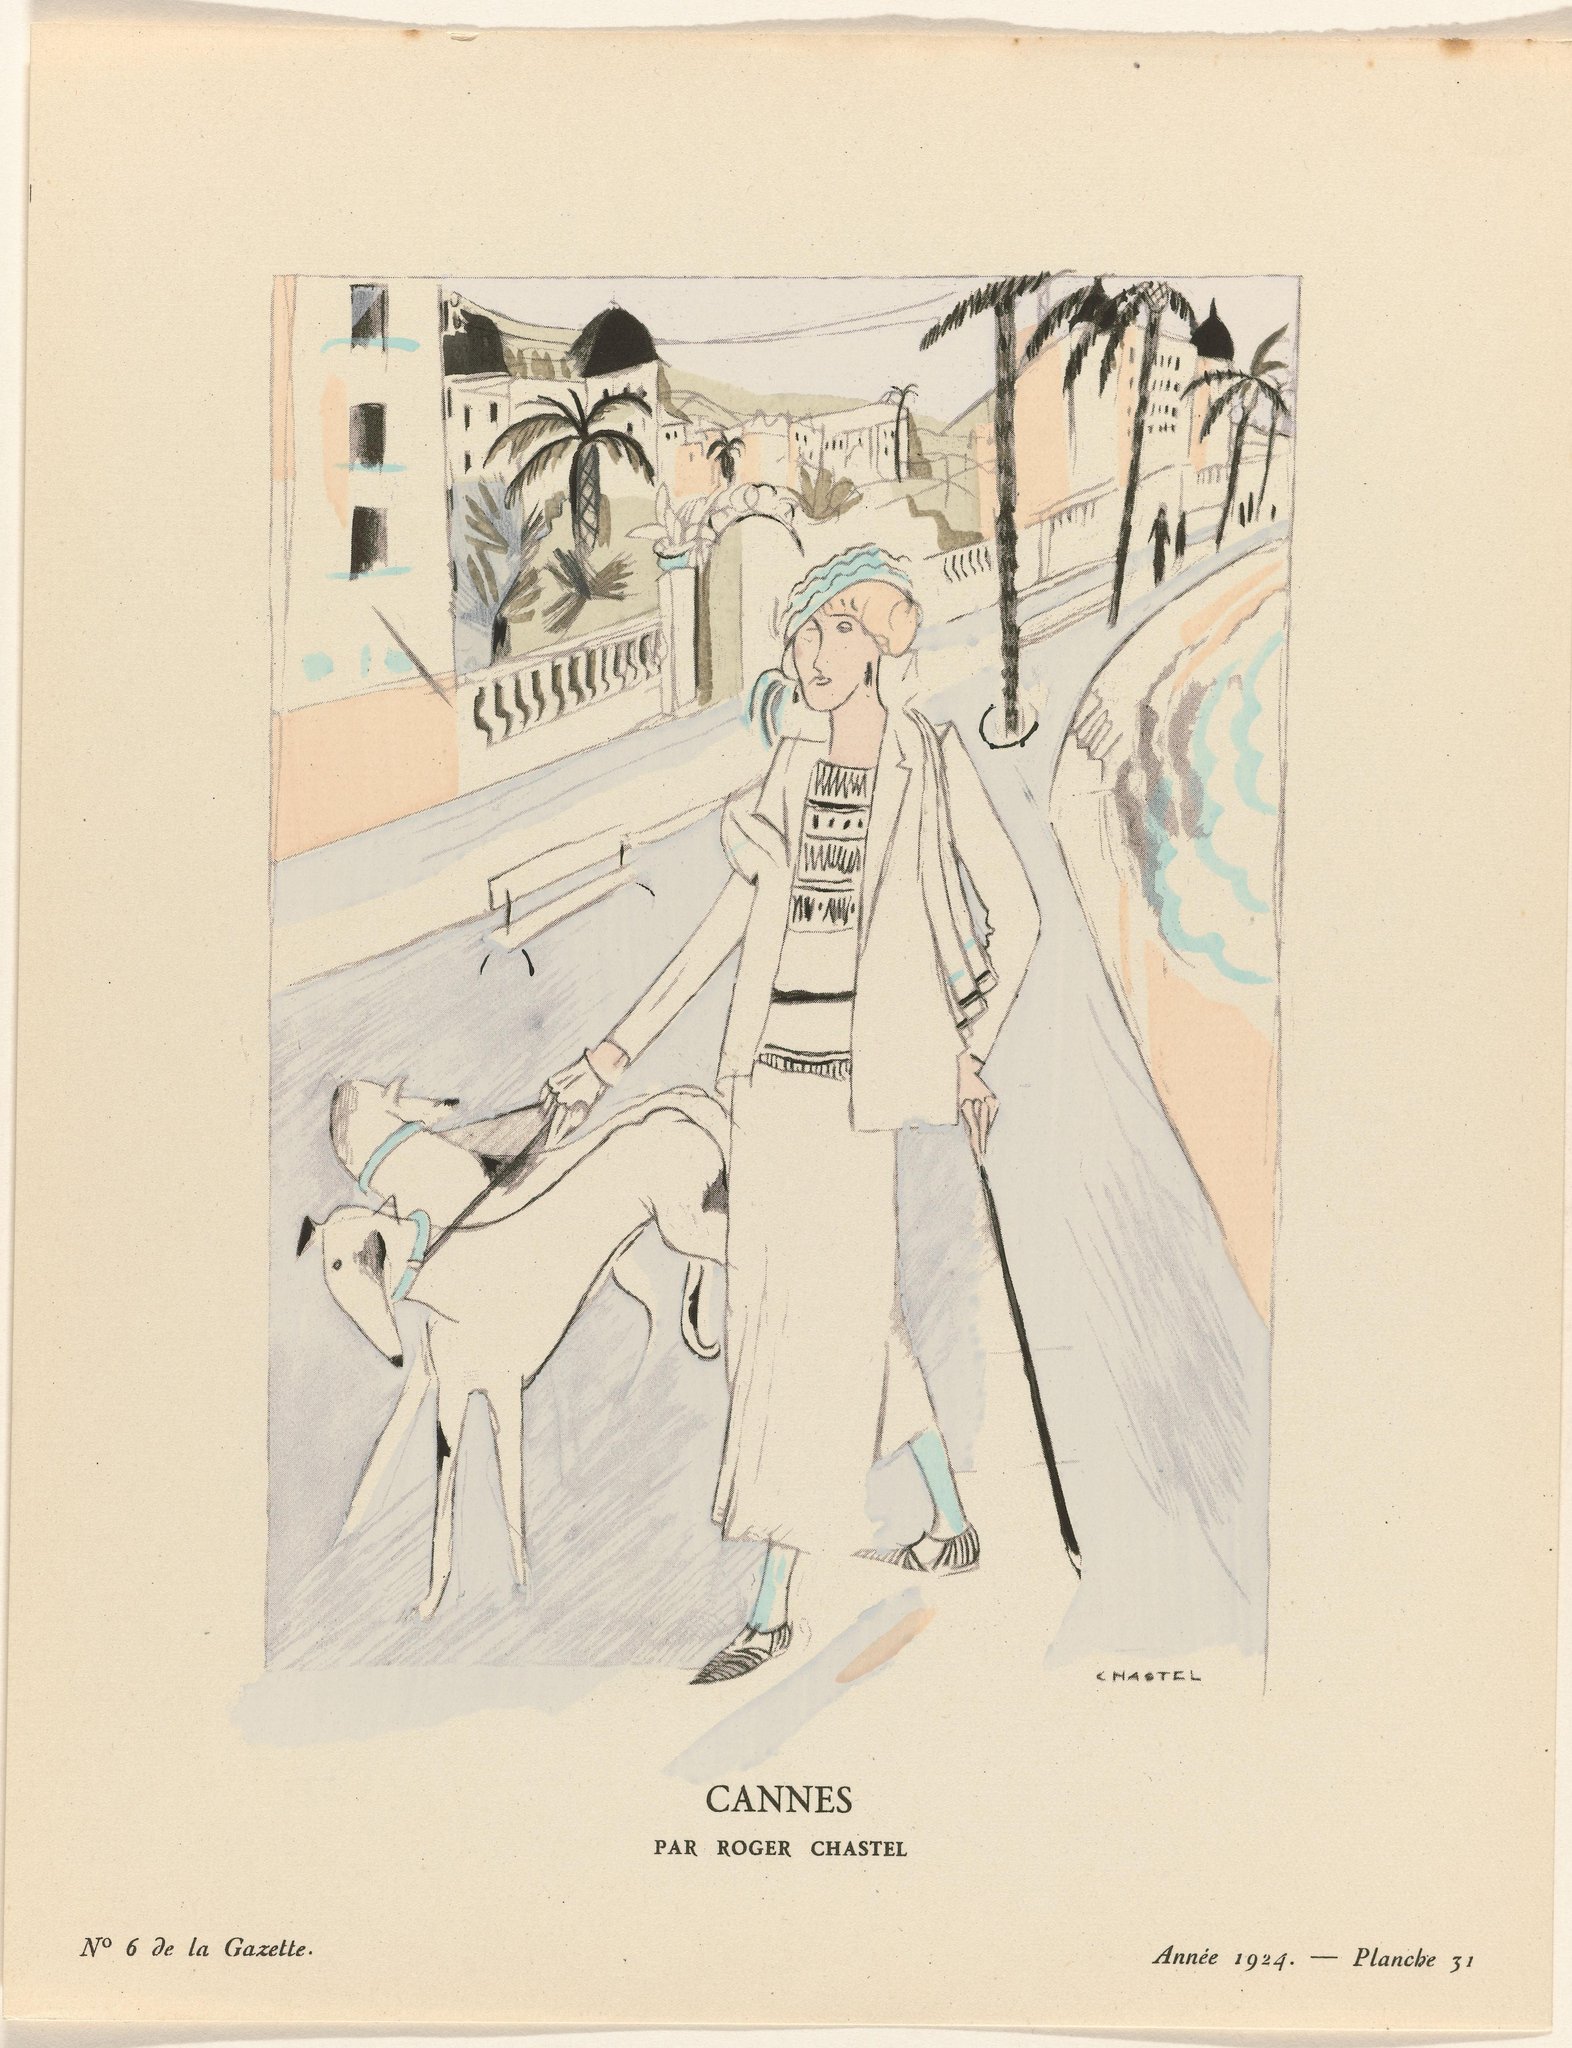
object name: fashion print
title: Gazette du Bon Ton. Art- Modes & Frivolités, 1924 - No. 6 : Cannes / Par Roger Chastel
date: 1924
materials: paper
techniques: hand coloring, letterpress printing, photochemical processes, pochoir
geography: paris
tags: walking-stick, staff, cane (+ women's clothes), head-gear (+ women's clothes), fashion plates, shoes, sandals (+ women's clothes), dress, gown (+ women's clothes), walking the dog, avenue, boulevard, promenade, esplanade, neck-gear ~ clothing (+ women's clothes)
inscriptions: date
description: Vrouw met twee honden aan de lijn, lopend over de boulevard. Zij draagt een japon, een jasje en een sjaal. Op het hoofd een hoed. In de linkerhand een wandelstok. Planche 31 uit Gazette du Bon Ton 1924, No. 6.